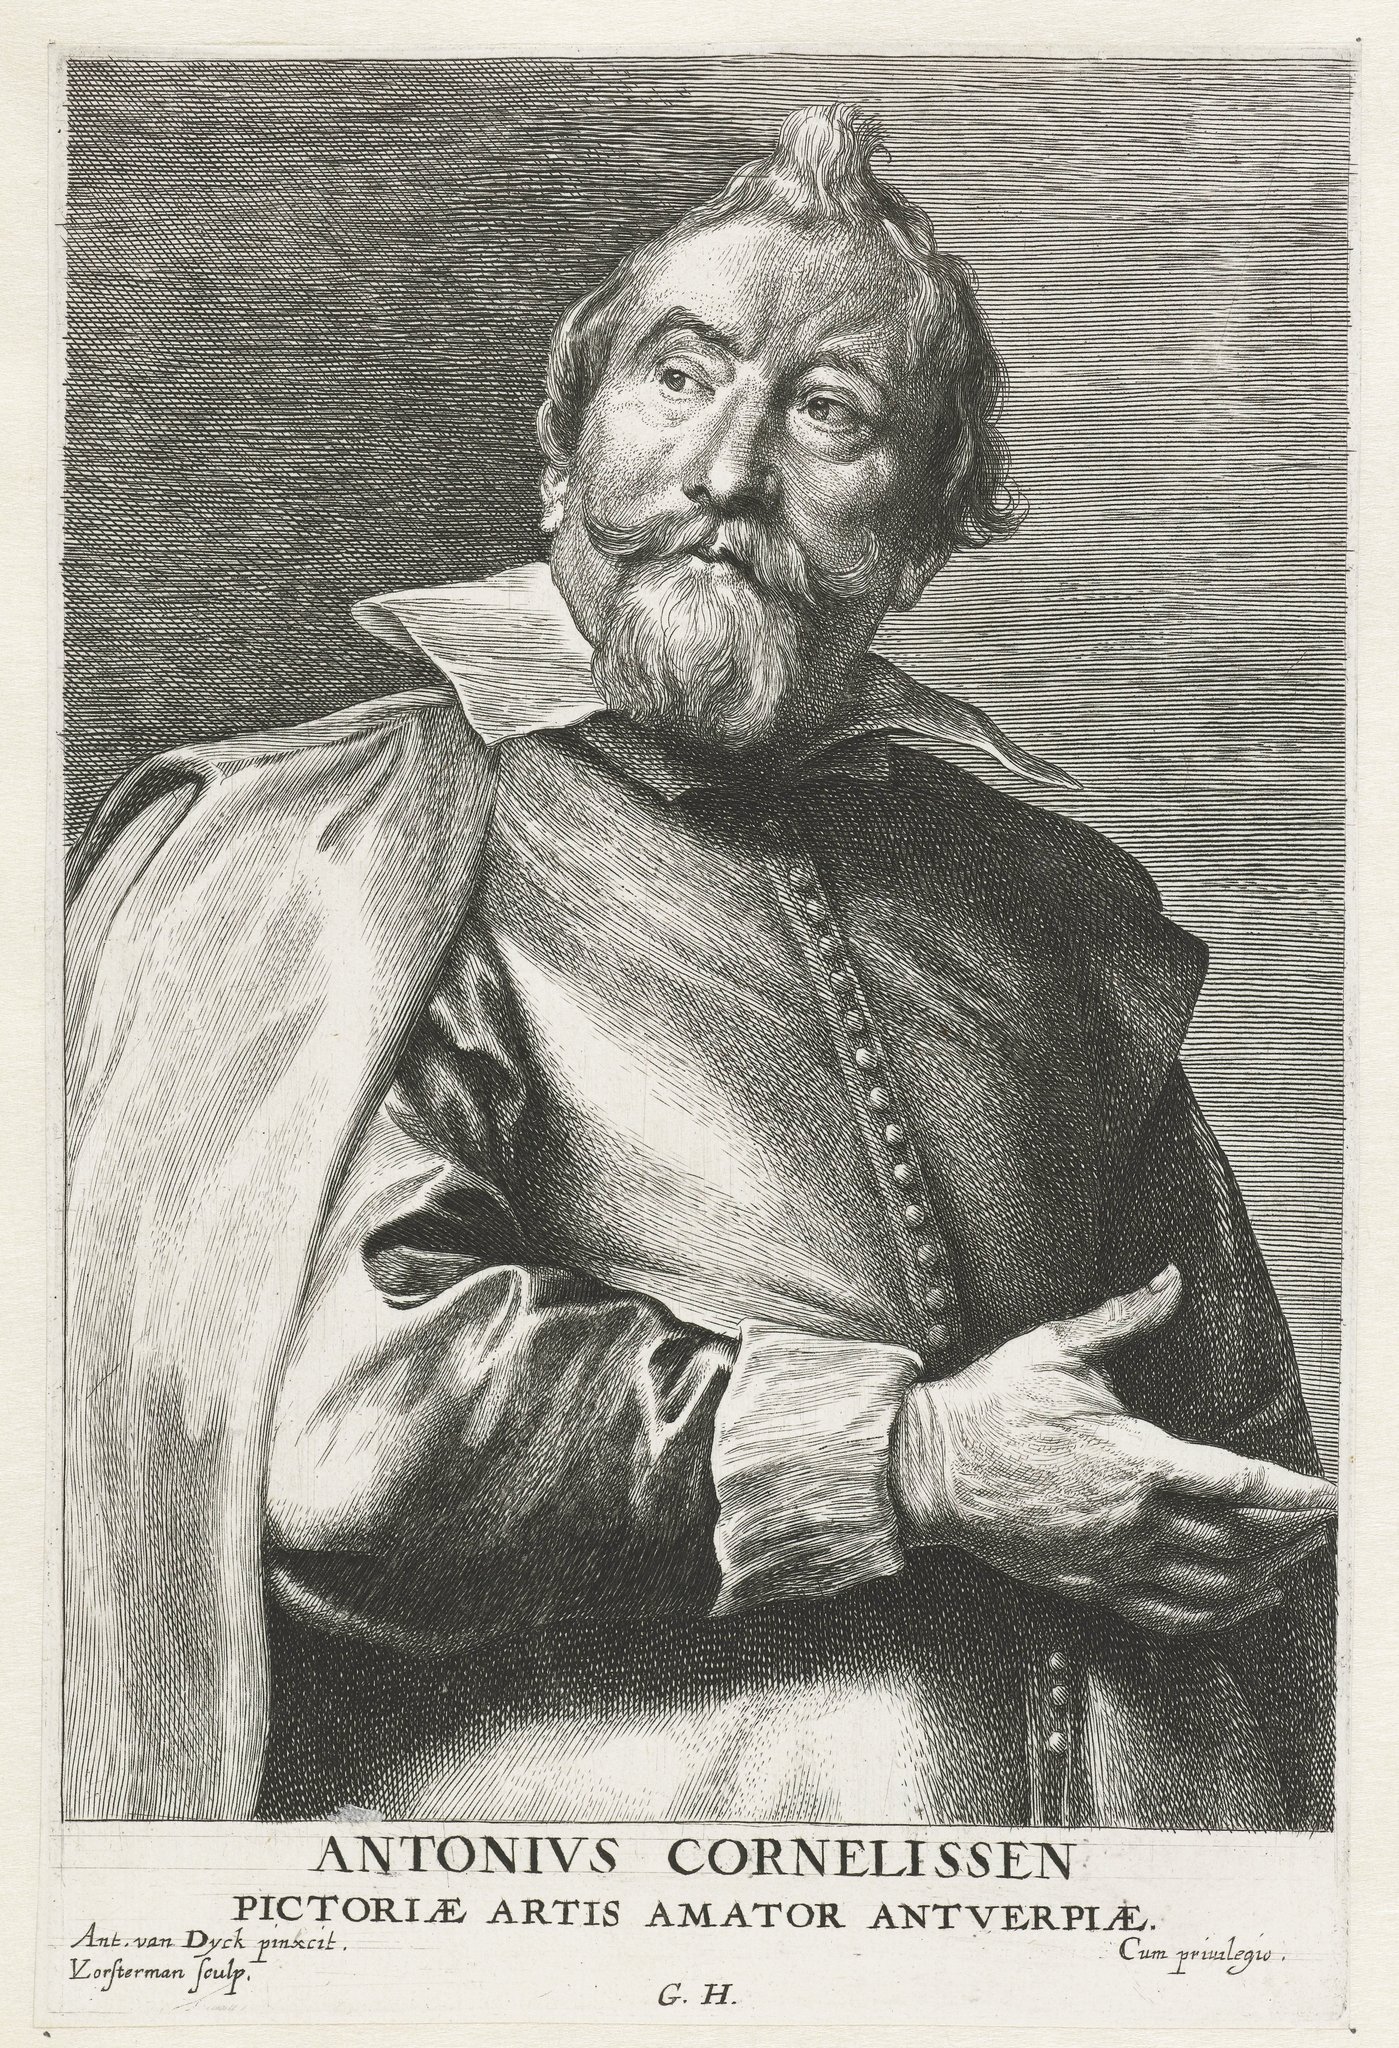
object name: print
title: Portret van de verzamelaar Antonius Cornelissen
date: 1630-1646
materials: paper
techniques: engraving, etching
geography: low countries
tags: art collector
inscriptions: collector's mark: Lugt 240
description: Portret van de verzamelaar Antoon Cornelissen met het onderschrift ANTONIVS CORNELISSEN PICTORIAE ARTIS AMATOR ANTVERPIAE